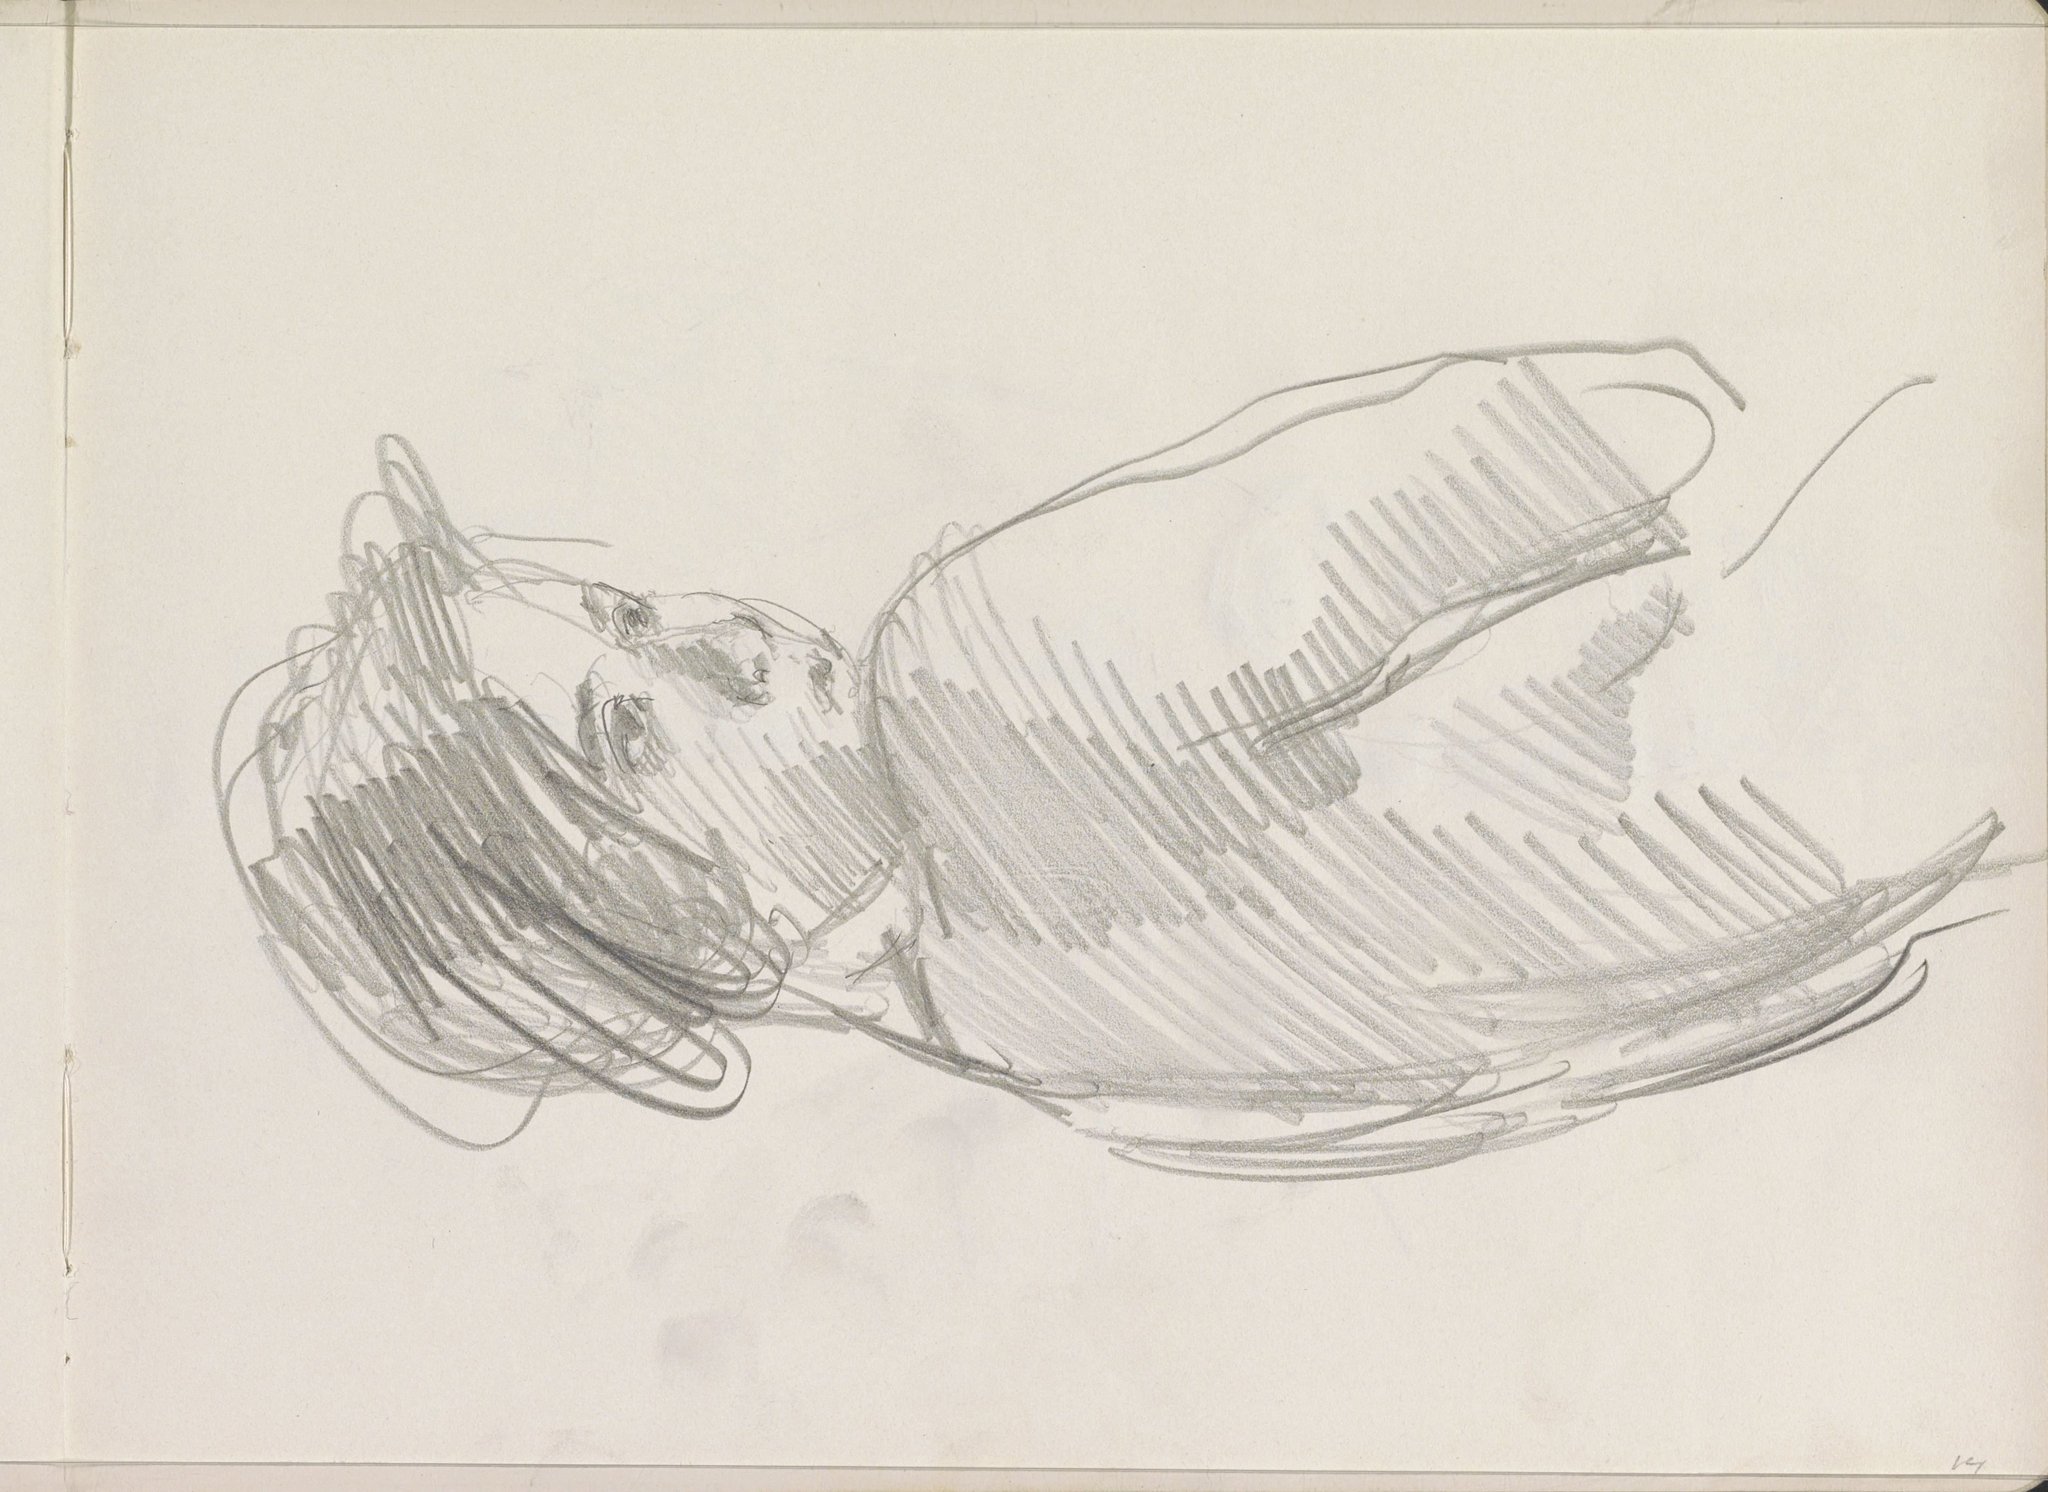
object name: sketchbook leaf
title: Vrouwelijk naakt, in profiel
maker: isaac israels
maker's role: draughtsman, painter, print maker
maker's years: 1865-1934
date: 1915-1934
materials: paper, pencil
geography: the hague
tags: the (nude) human figure; 'corpo humano' (ripa) - aa - female human figure (+ standing)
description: Ze kijkt naar rechts en houdt haar rechterarm voor haar lichaam. Blad 14 recto uit schetsboek III met 36 bladen.